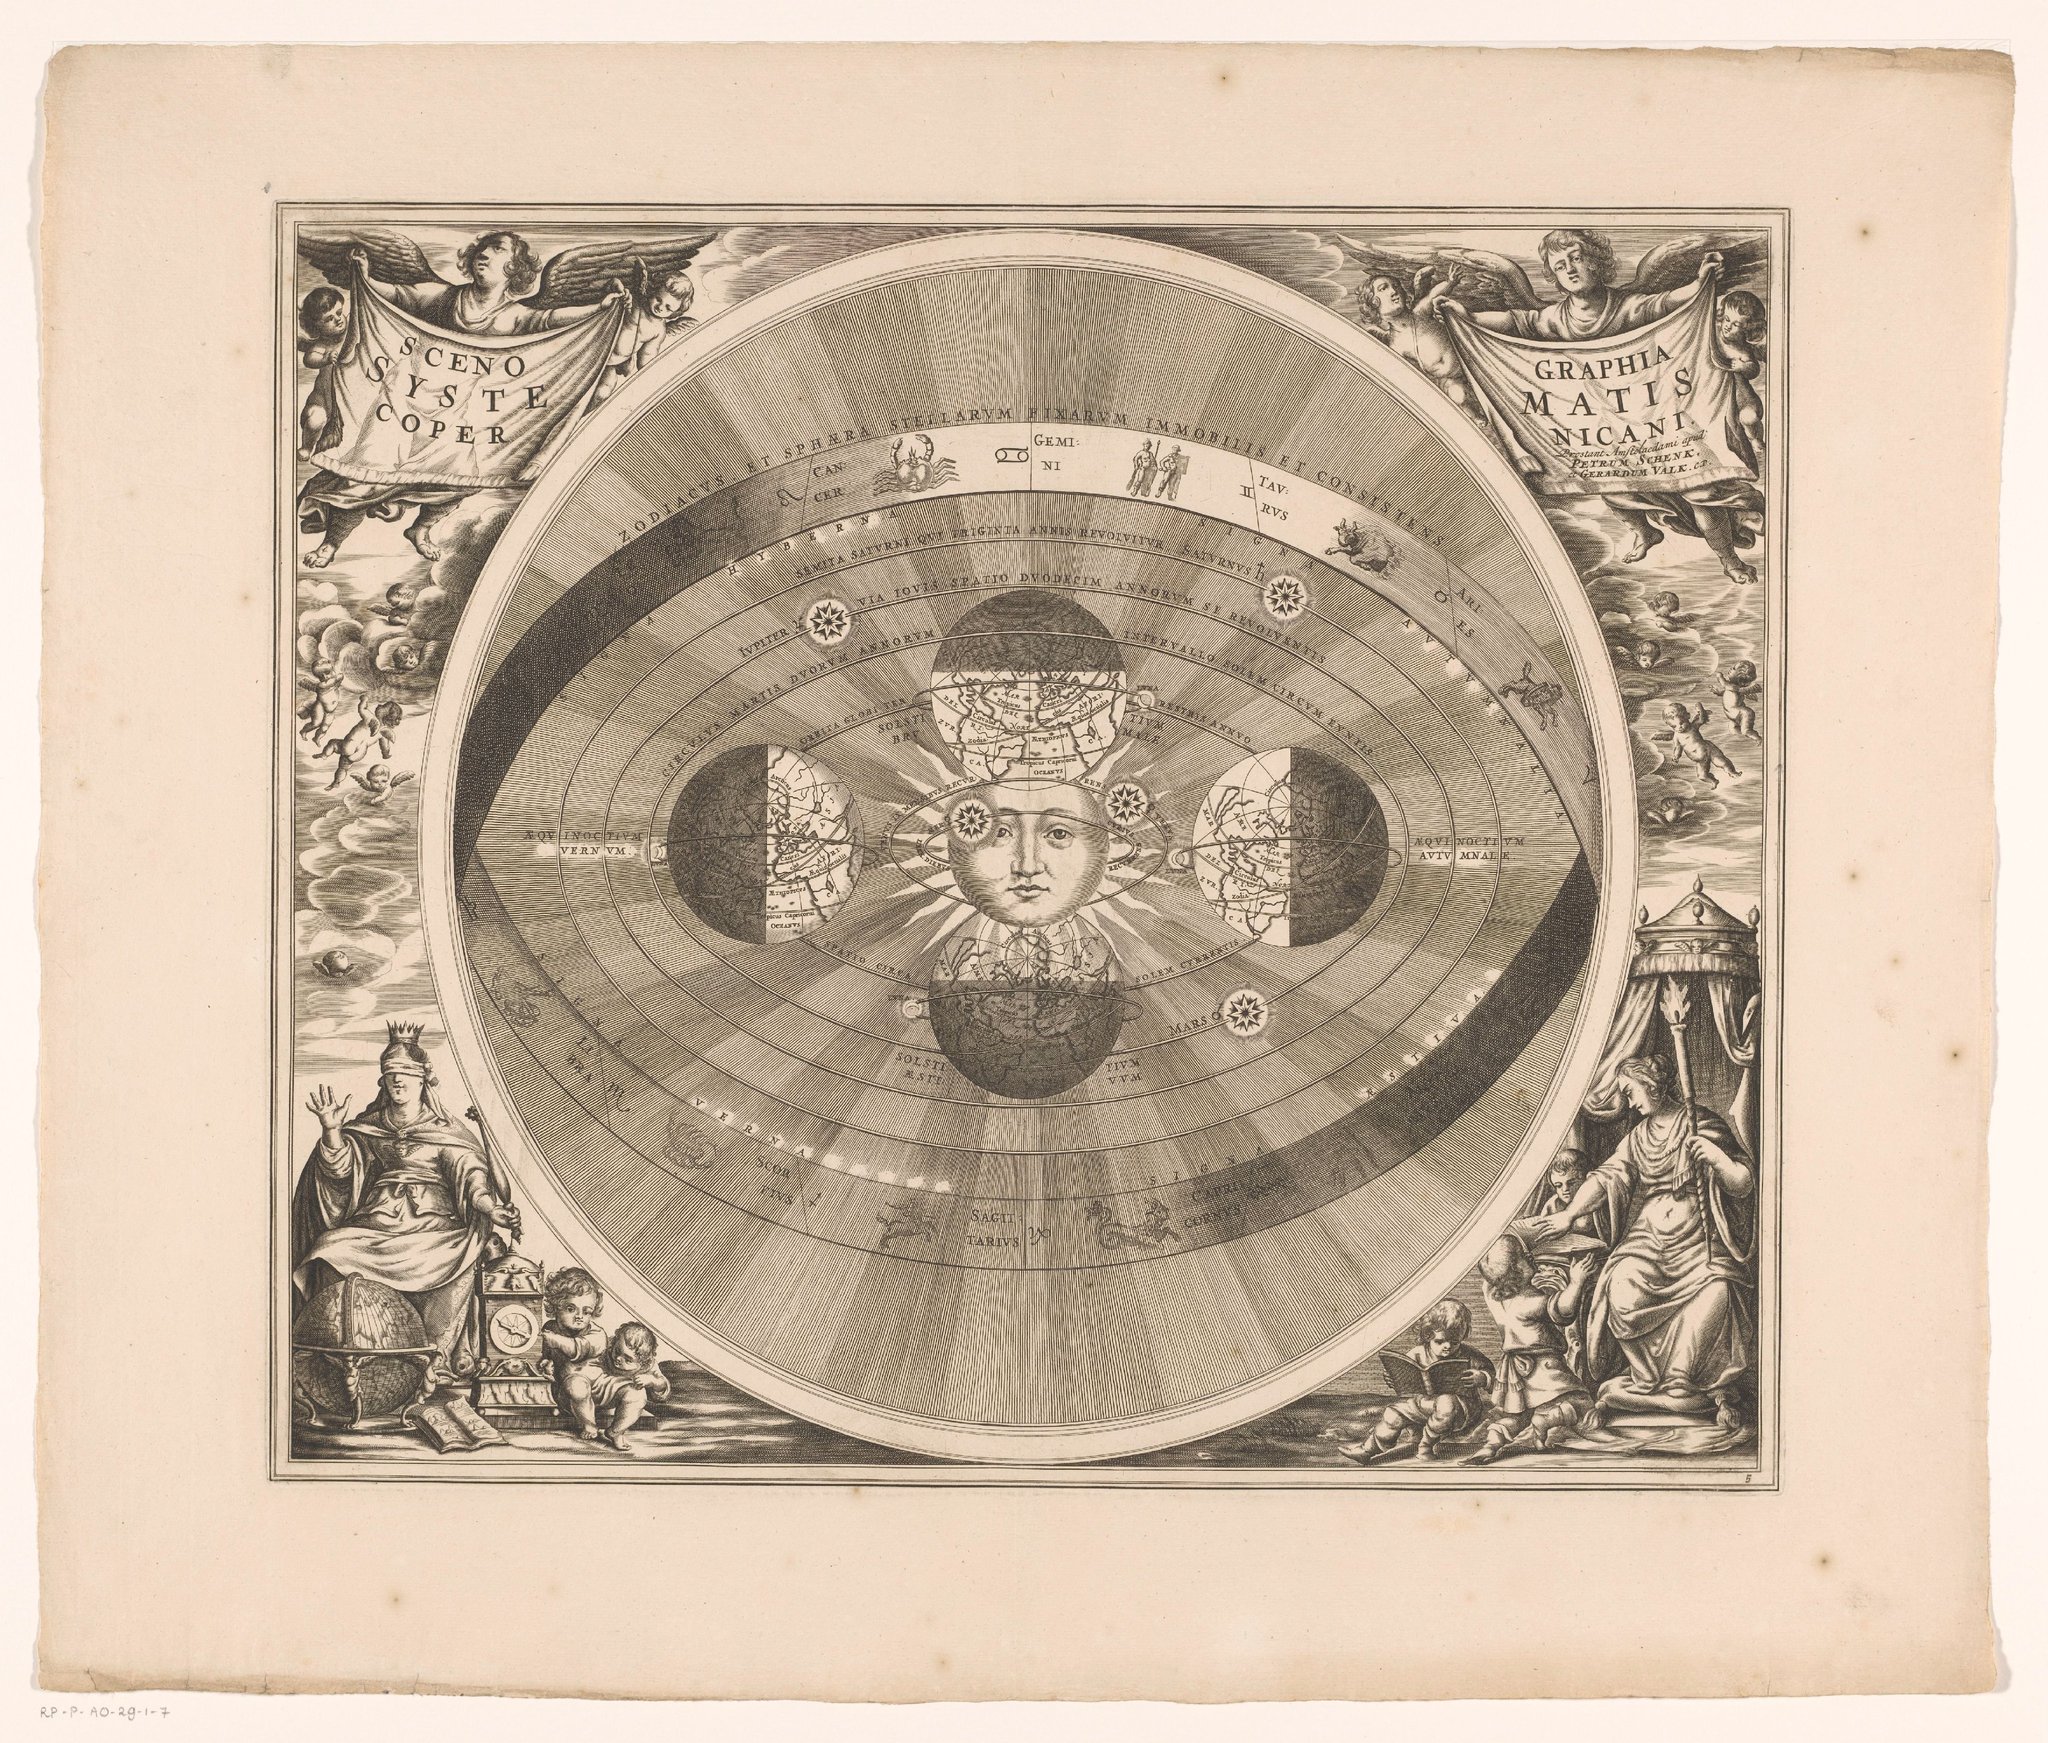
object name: print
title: Scenographia sytematis Copernicani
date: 1660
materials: paper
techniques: engraving, etching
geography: amsterdam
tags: zodiac; the twelve zodiacal signs together, star-chart, star map, planets; planetary system, solar system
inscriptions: collector's mark: Lugt 2228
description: Hemelkaart waar het heliocentrische stelsel van Nicolaas Copernicus op te zien is. In het midden de zon, met een gezicht, daaromheen de banen van de planeten en de aarde om de zon. De aarde wordt vier keer weergegeven in zijn baan om de zon, bij het begin van elk astronomisch seizoen. In de buitenste ring de dierenriem. Links- en rechtsboven de titelcartouches, gedragen door putti. Linksonder een geblinddoekte, gekroonde vrouw zittend achter een hemelglobe en een pendule. Rechtsonder een zittende vrouw met een fakkel, lezend in een boek dat voor haar wordt open gehouden. Rechtsonder genummerd: 5.